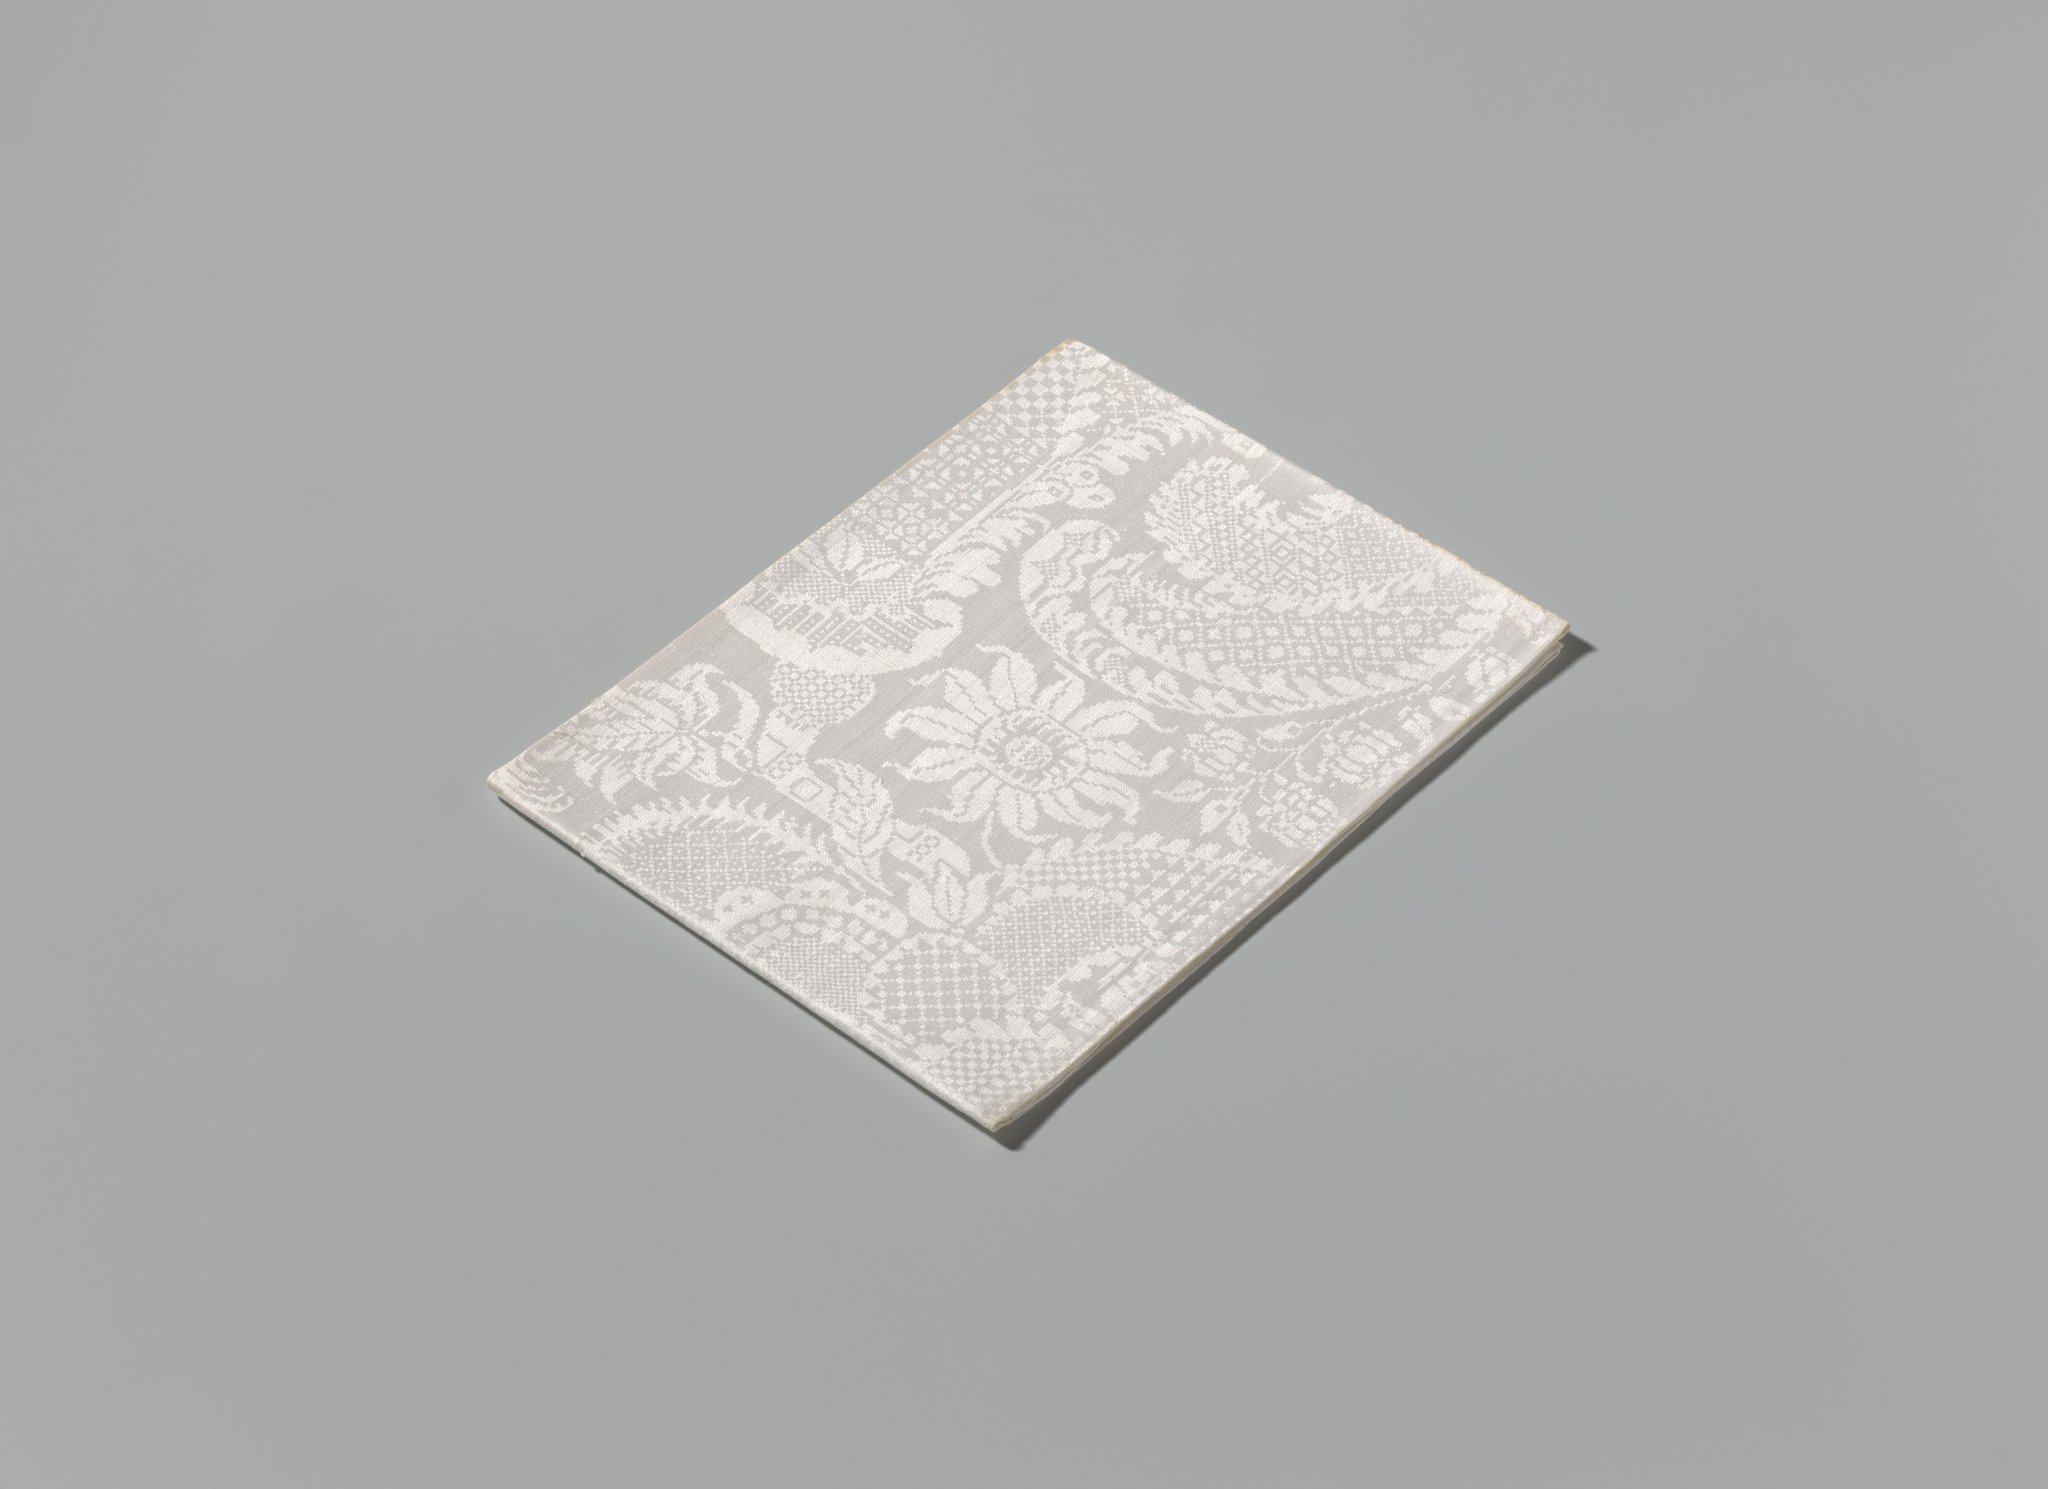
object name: napkin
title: Servet van linnendamast met een voluutpatroon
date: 1723-1730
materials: linen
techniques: damask, weave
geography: northern netherlands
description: Wit linnendamasten servet met patroon van voluten, merk: kroon WG 26.